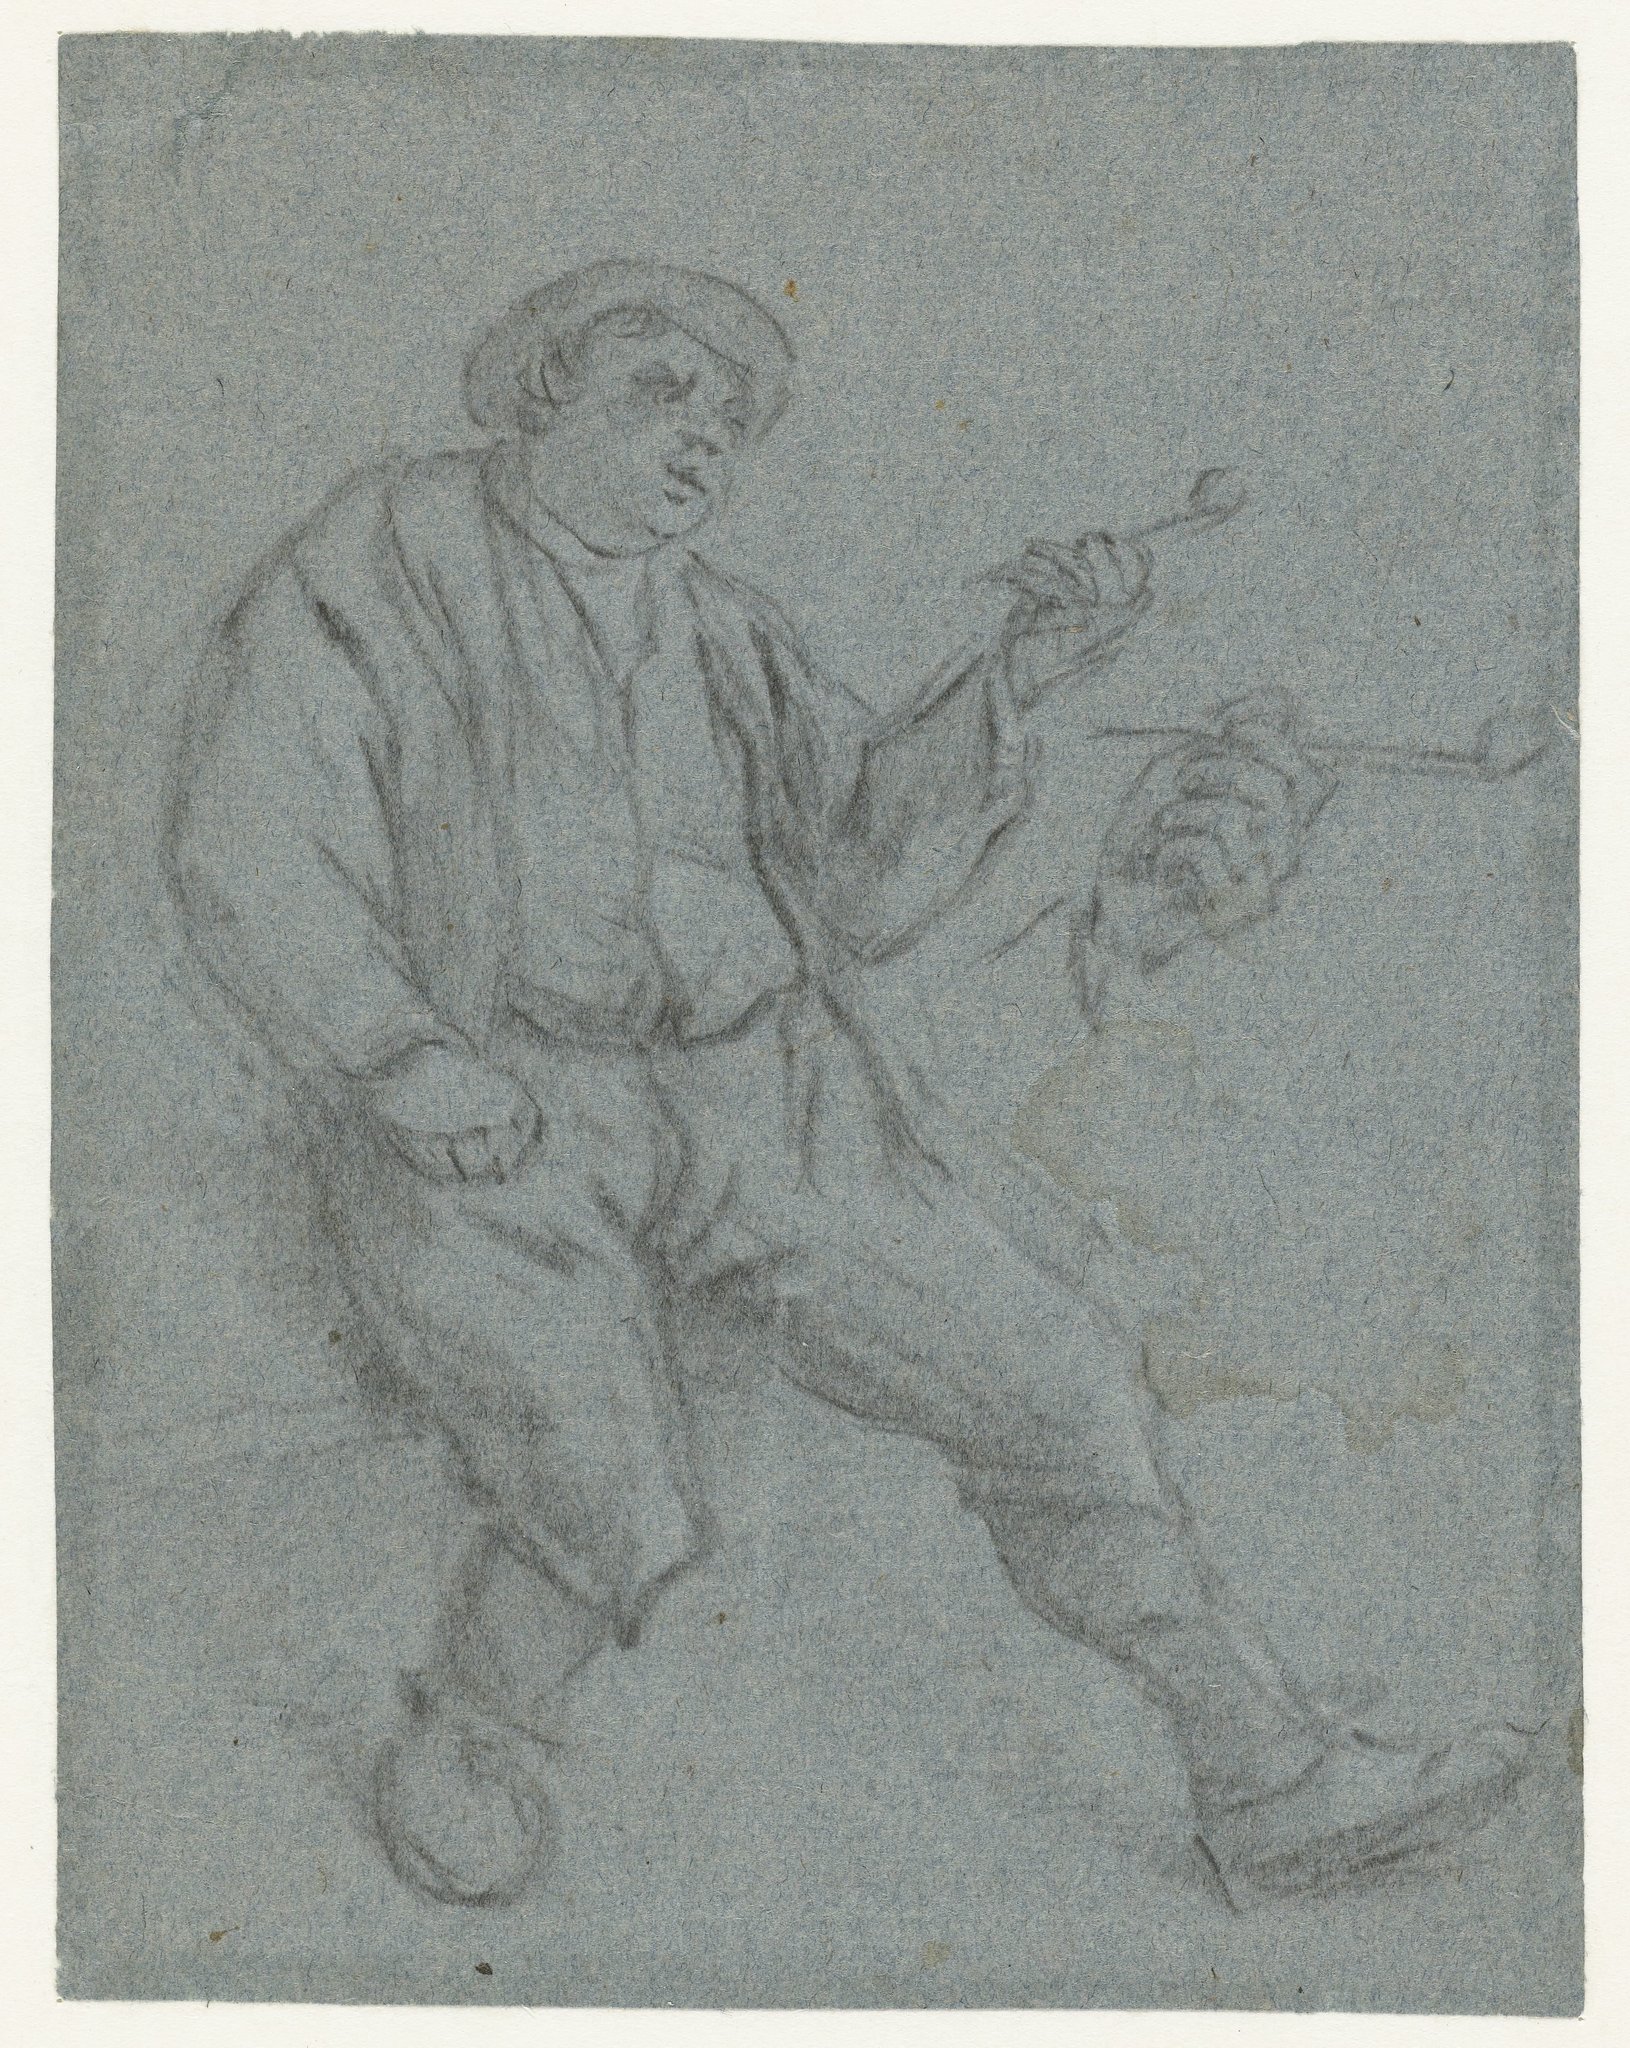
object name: drawing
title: Zittende boer met pijp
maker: adriaen van ostade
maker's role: draughtsman, painter, print maker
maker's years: 1610-1685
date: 1659-1670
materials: chalk, paper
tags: sitting figure, farmers, pipe ~ tobacco (+ taking (particular) foodstuffs: eating, drinking, smoking, chewing, etc.)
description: Een zittende boer met een pijp in de linkerhand; met detailstudie van hand met pijp.